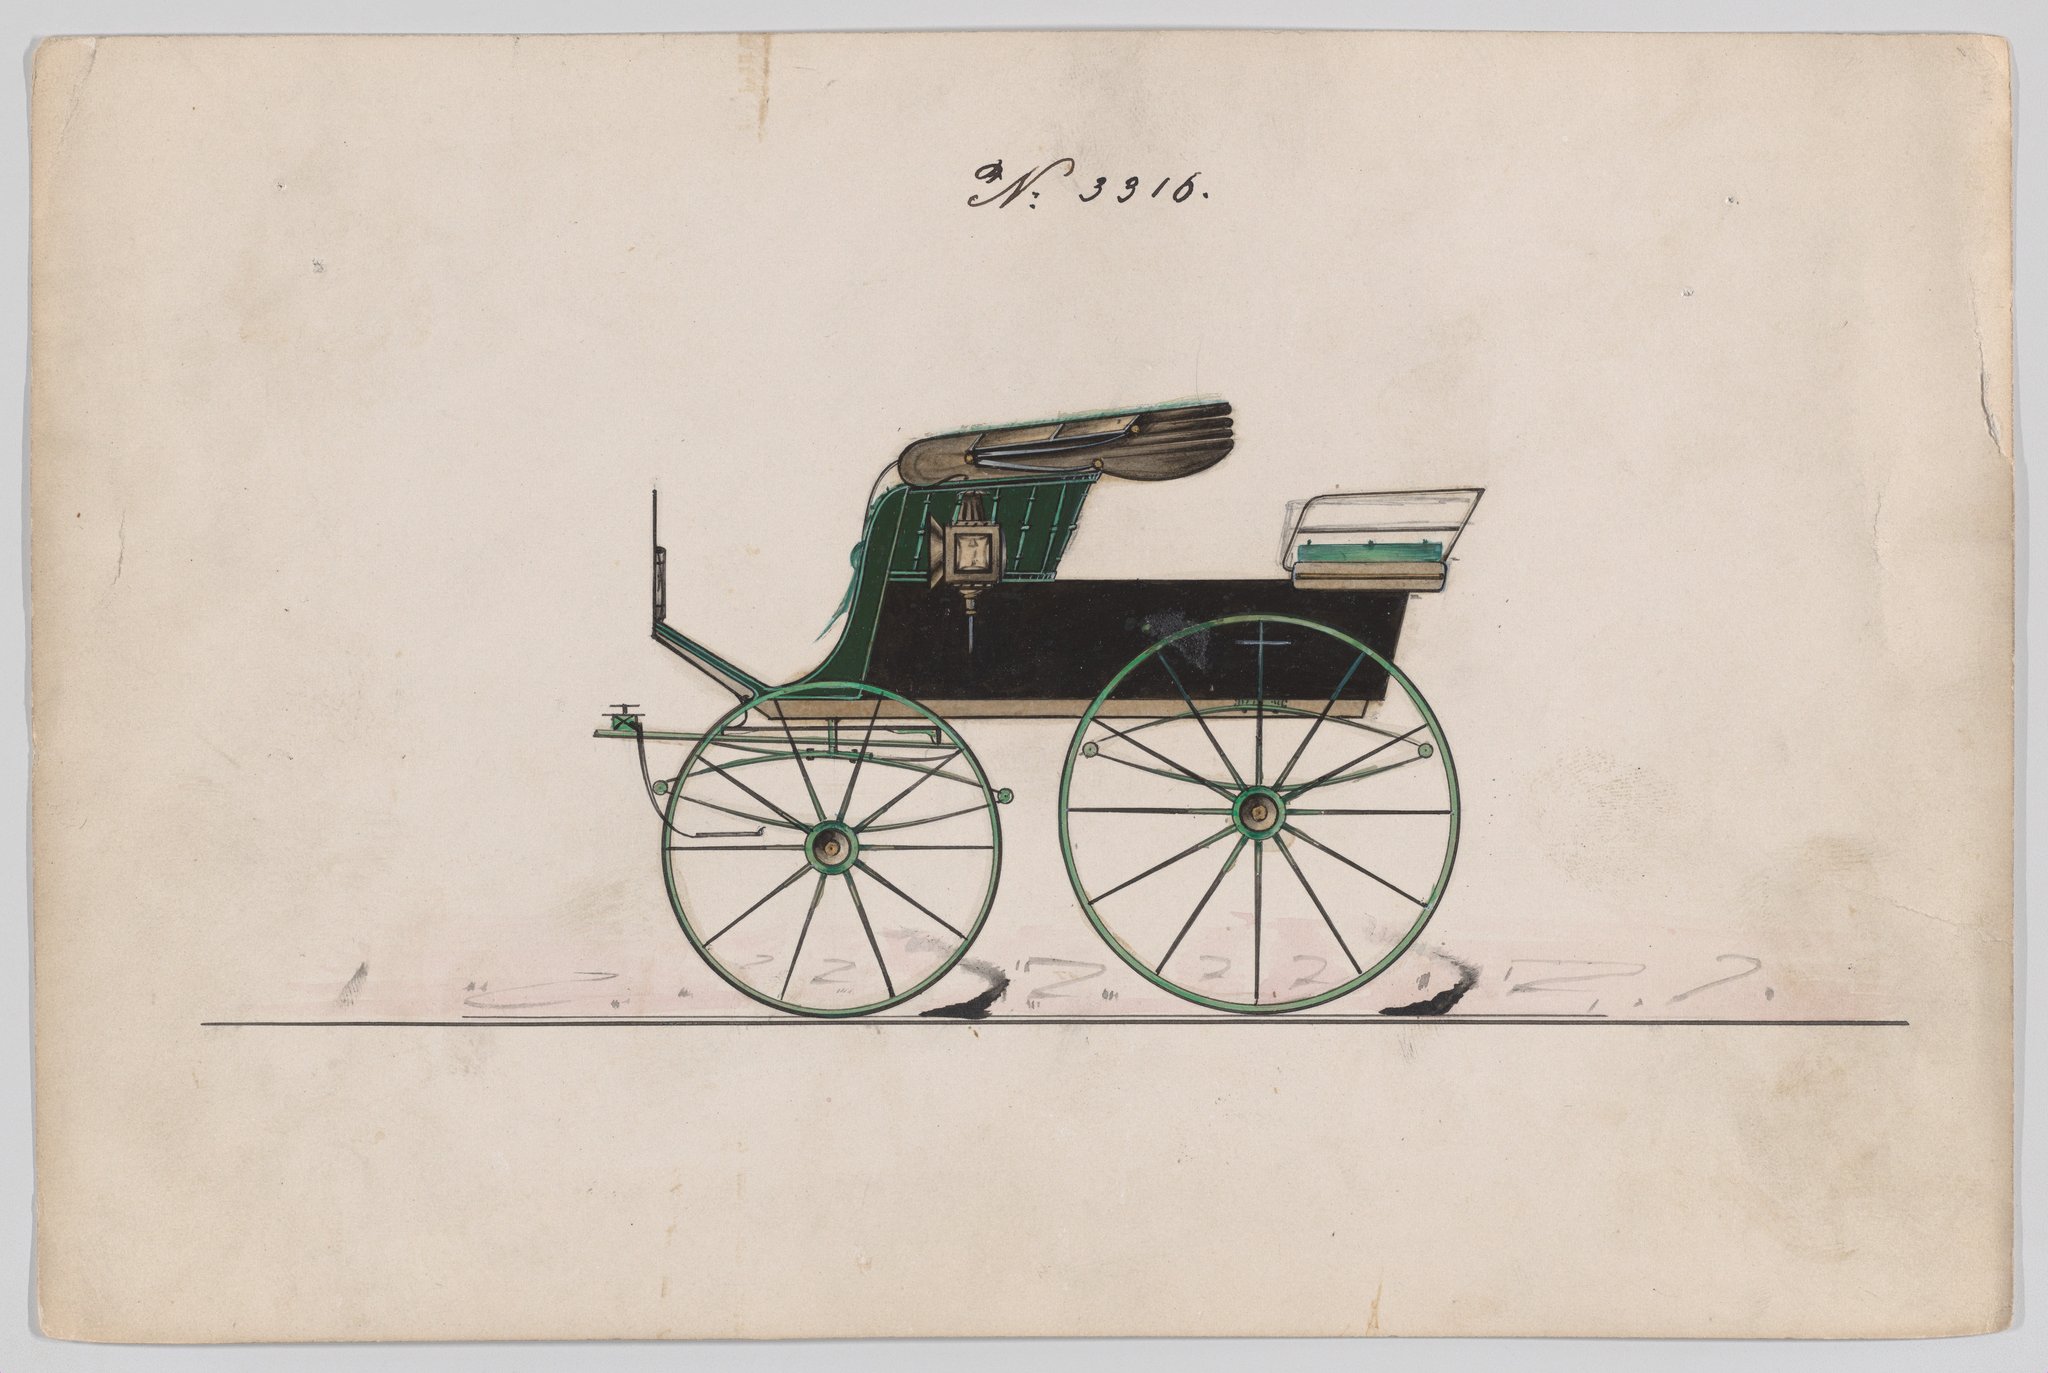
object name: drawing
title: Design for Stanhope Phaeton, no. 3316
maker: brewster & co.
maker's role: manufacturer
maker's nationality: american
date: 1877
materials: gouache, graphite, gum arabic, ink, watercolor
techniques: pen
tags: carriages